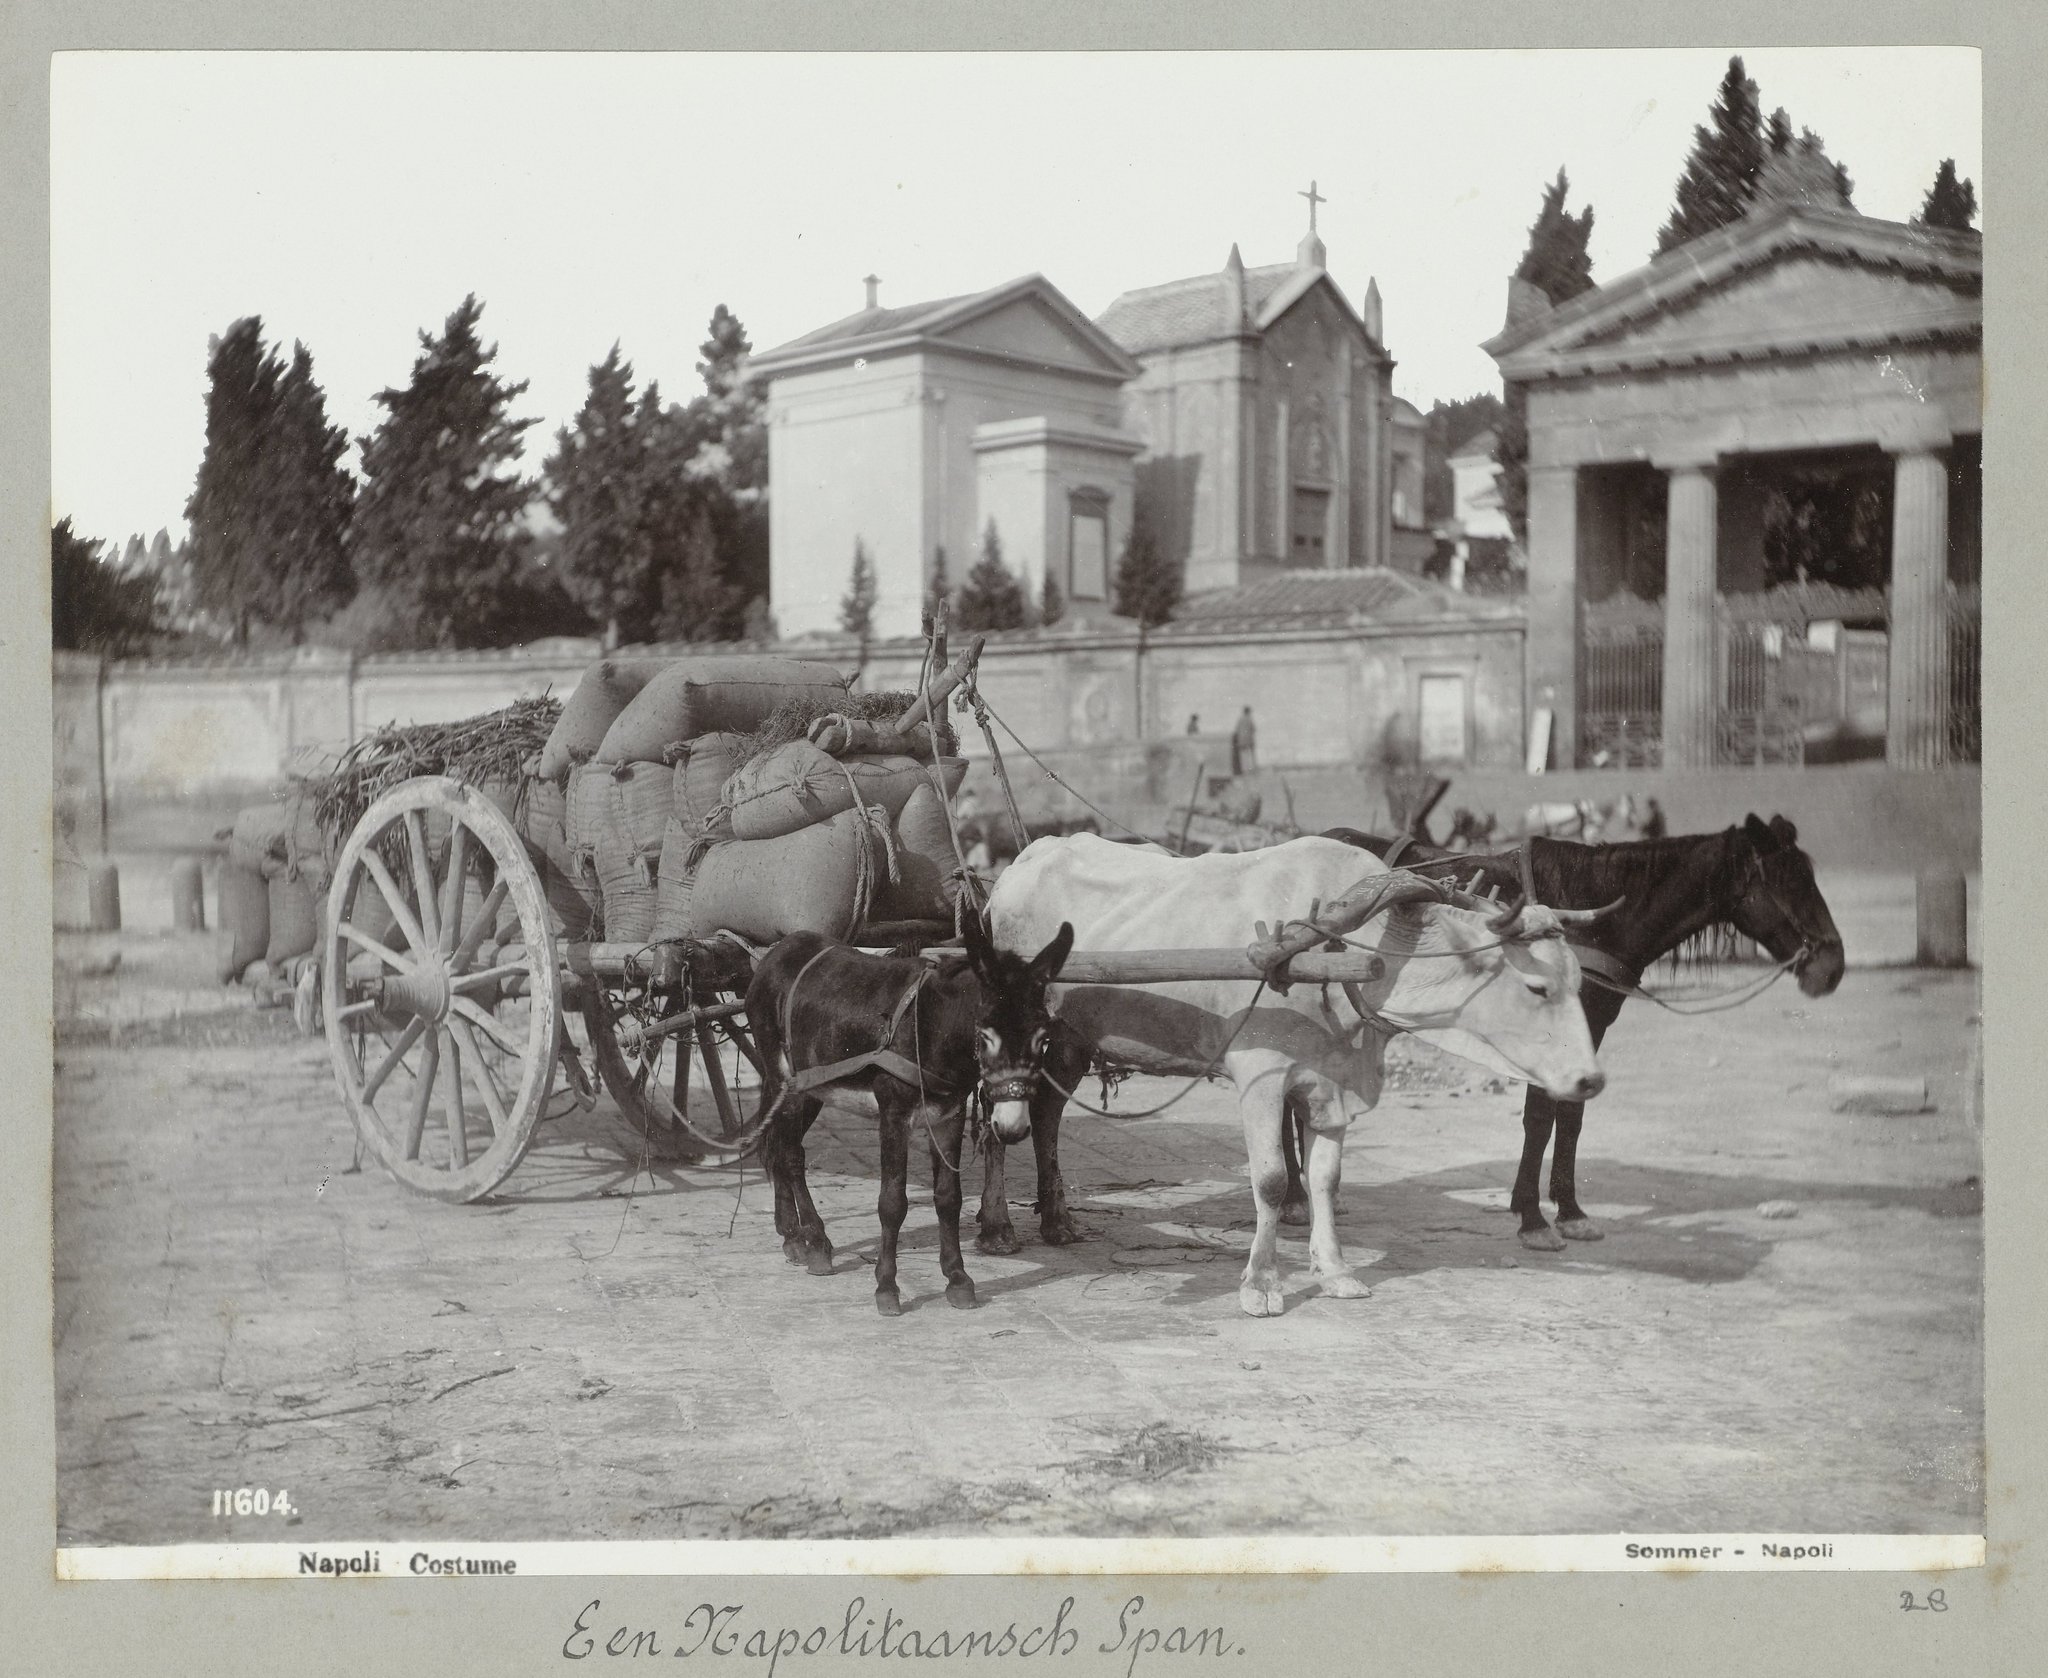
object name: photograph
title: 11604 Napoli costume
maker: giorgio sommer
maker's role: fotograaf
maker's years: 1834-1914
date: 1893-1903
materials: cardboard, photographic support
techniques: albumen print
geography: naples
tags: naples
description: Een volgeladen kar in de straten van Napels voortgetrokken door een koe, een paard en een ezel.